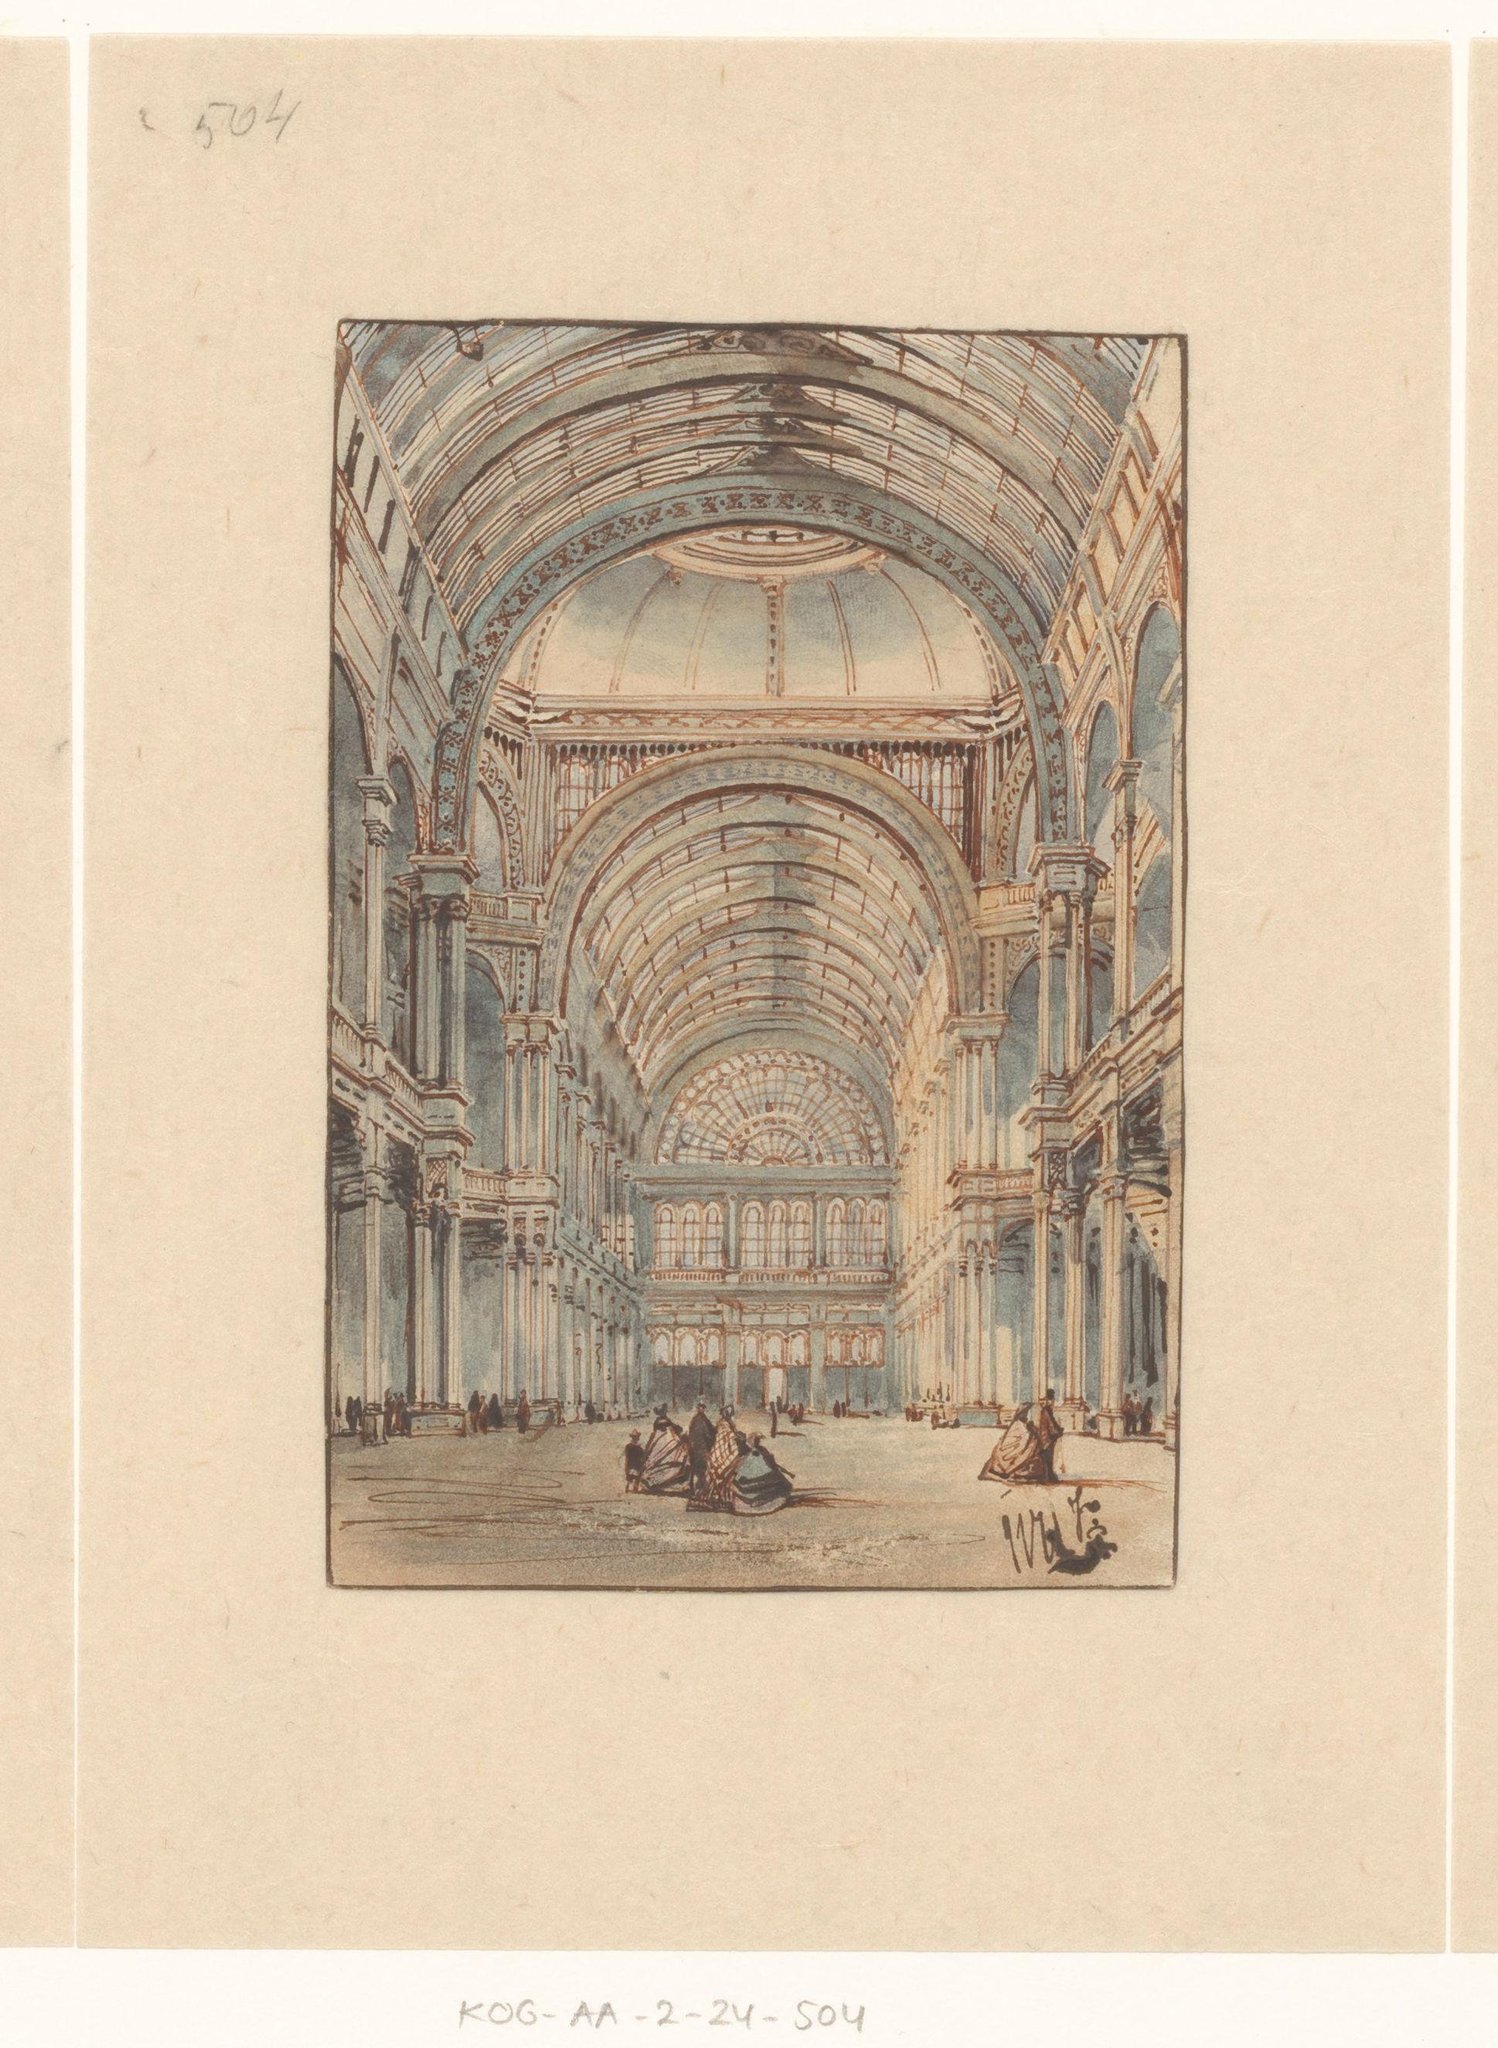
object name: drawing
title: Interieur van het Paleis voor Volksvlijt, gezien naar de Grote Zaal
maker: willem hekking jr.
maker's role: print maker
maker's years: 1825-1904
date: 1864-1904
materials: ink, paper, watercolor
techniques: brush, pen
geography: amsterdam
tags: permanent exhibition, museum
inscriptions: signature: ‘WHjr’, collector's mark: Lugt 800a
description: Tekening binnen de Atlas Van Eck ingedeeld op wijknummer 24.